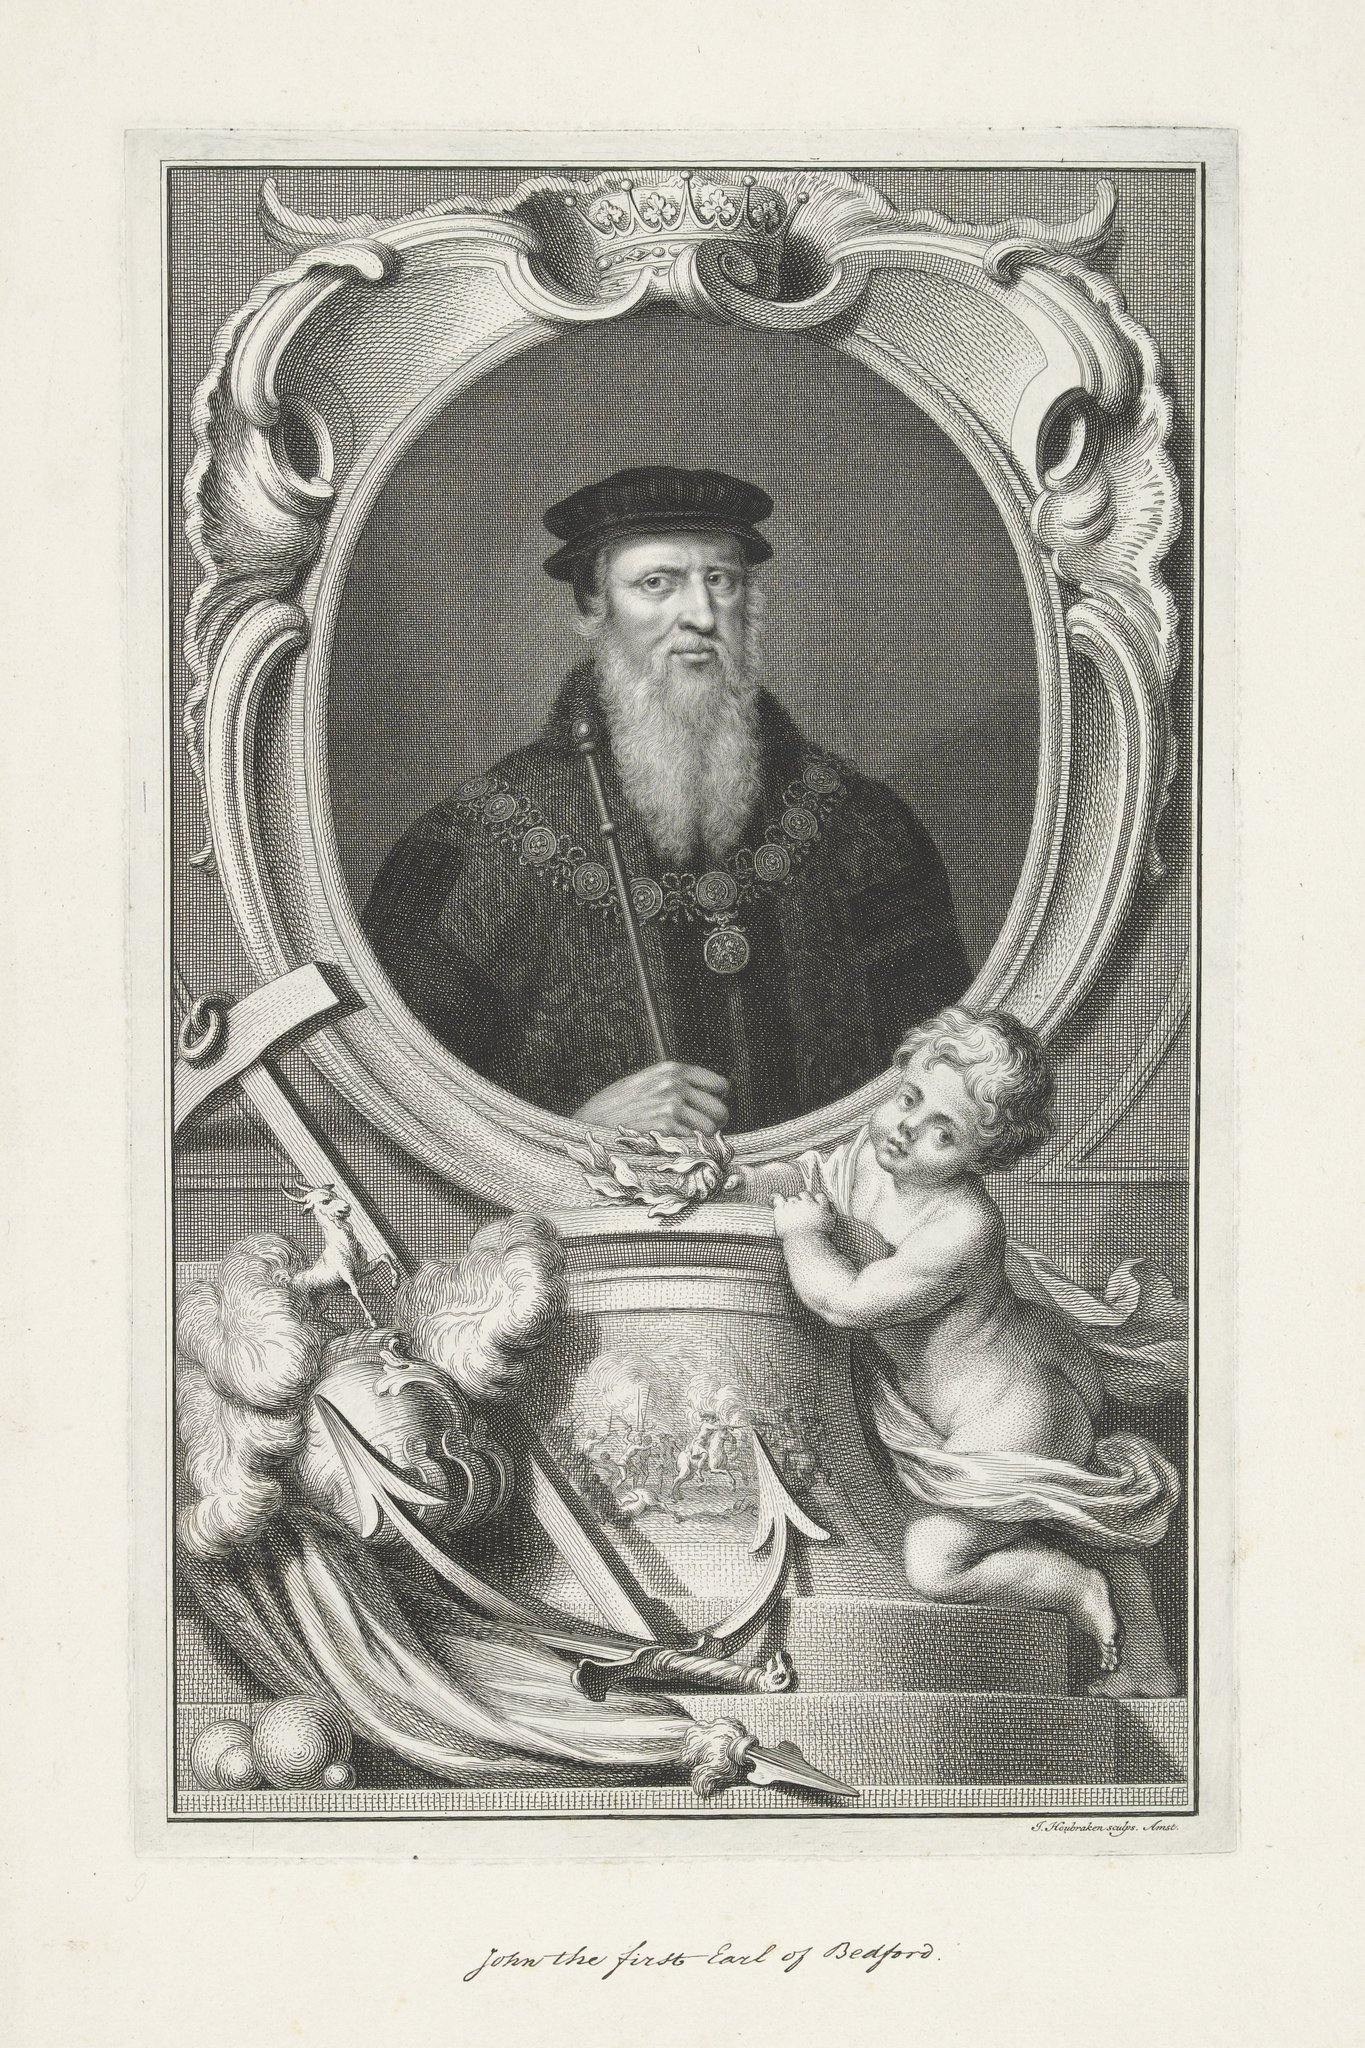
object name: print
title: Portret van John Russell, graaf van Bedford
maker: jacob houbraken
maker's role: draughtsman, print maker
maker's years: 1698-1780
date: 1737-1739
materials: paper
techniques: engraving, etching, pen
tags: dorset, john russell (1e graaf van bedford)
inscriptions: name: ‘John the first Earl of Bedford’, collector's mark: Lugt 240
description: Prent ook gebruikt in: Thomas Birch. The heads of illustrious persons of Great Britain : engraved by Houbraken, and Vertue, with their lives and characters. London: John en Paul Knapton, 1743-1751.